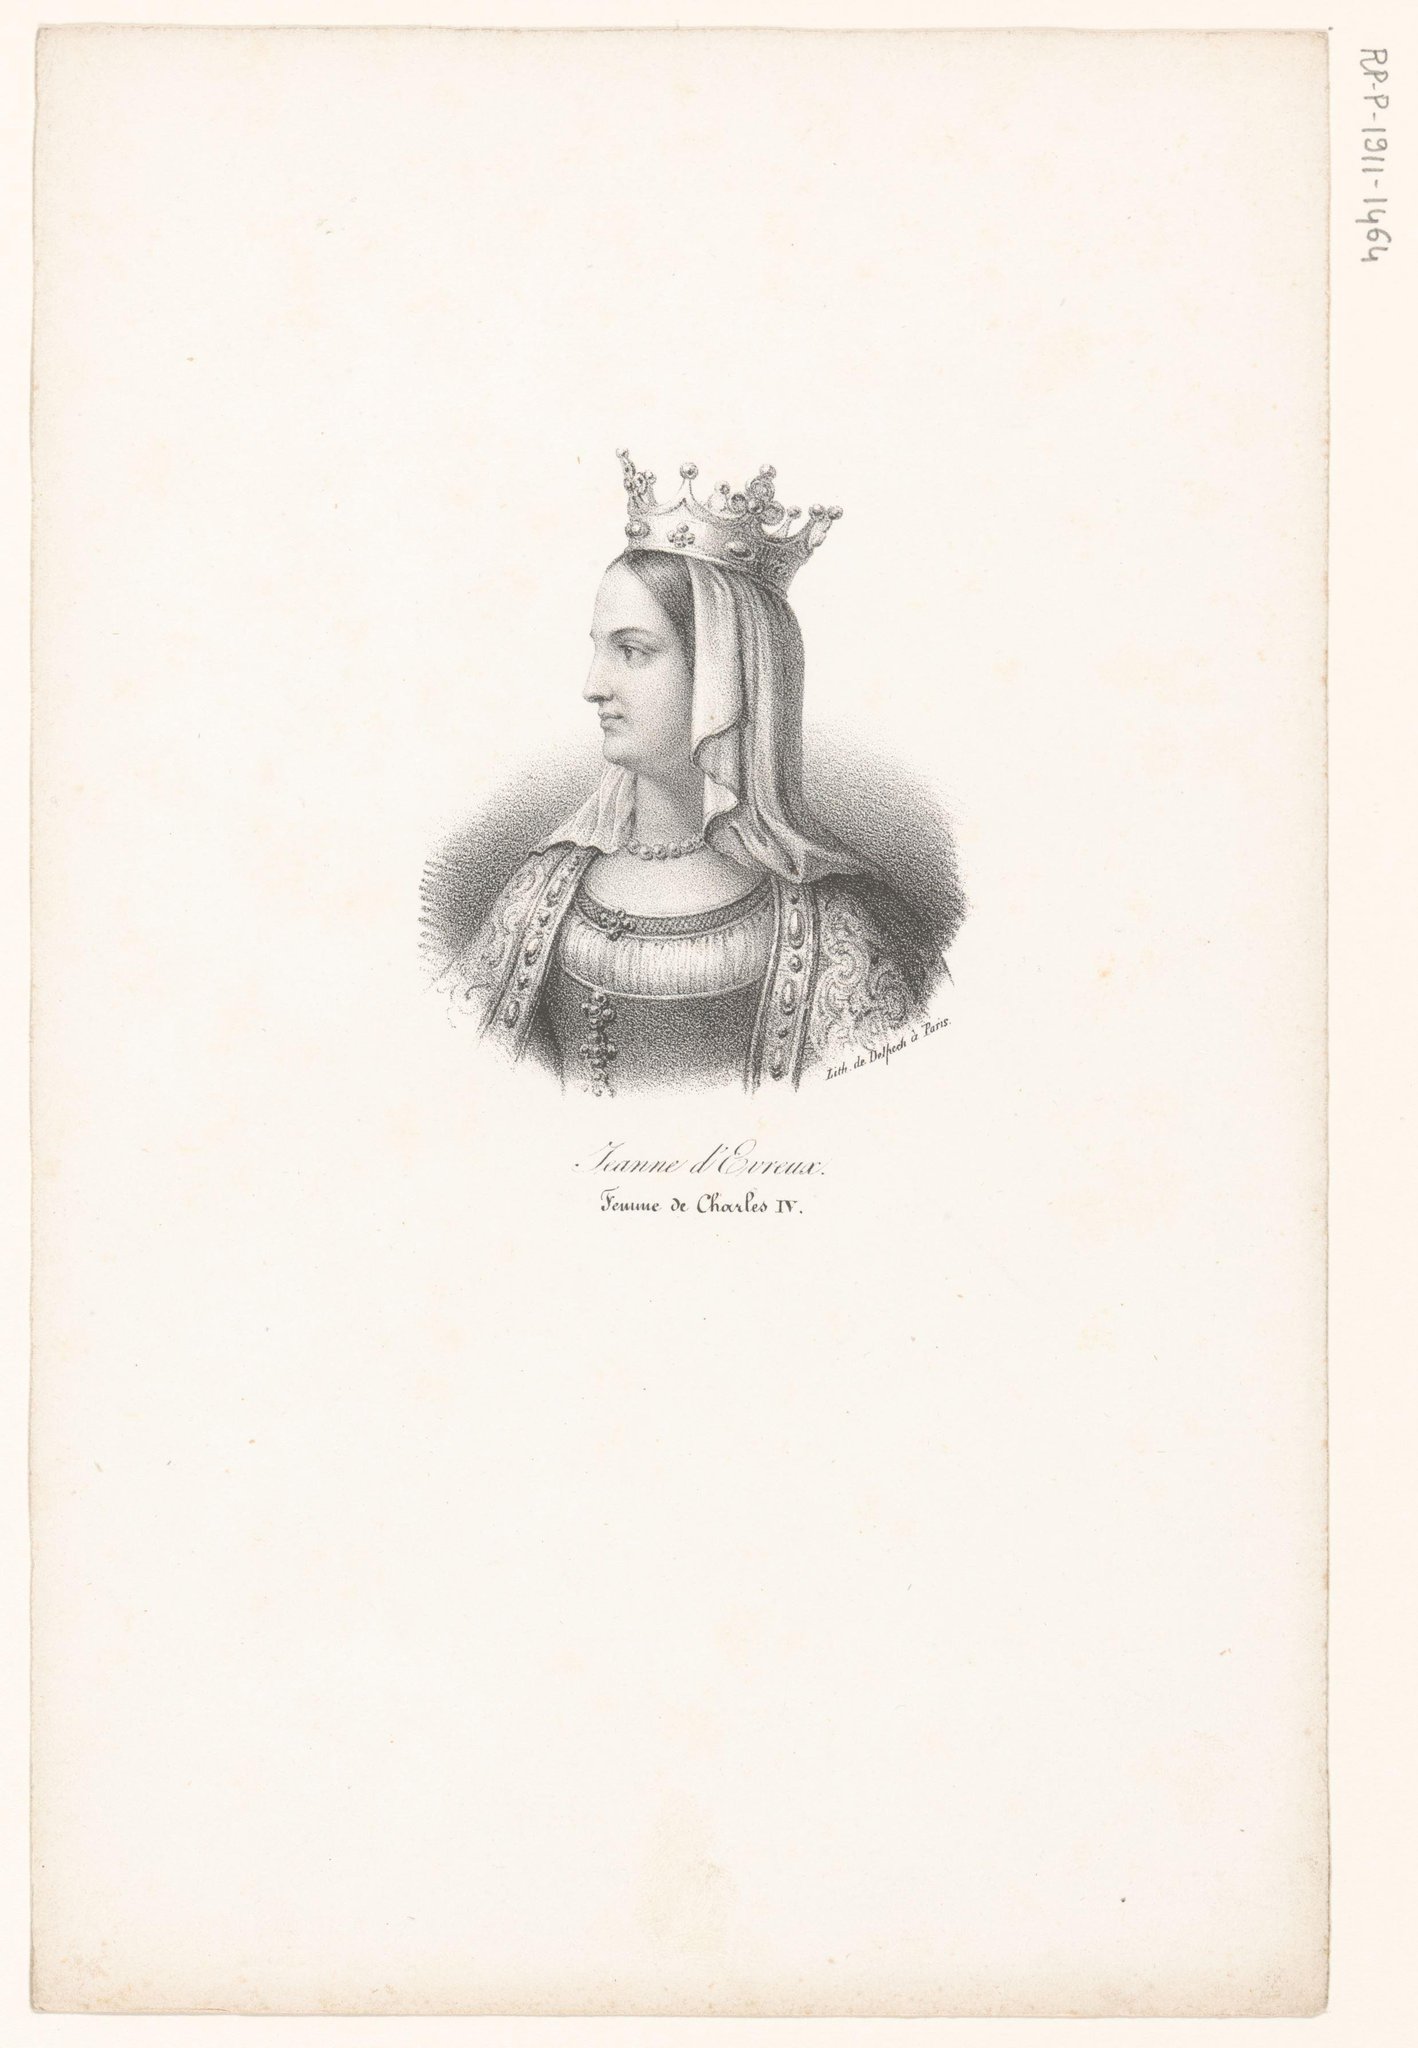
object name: print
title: Portret van Johanna van Évreux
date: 1818-1842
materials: paper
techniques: lithograph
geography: paris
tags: historical persons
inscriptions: collector's mark: Lugt 2228a